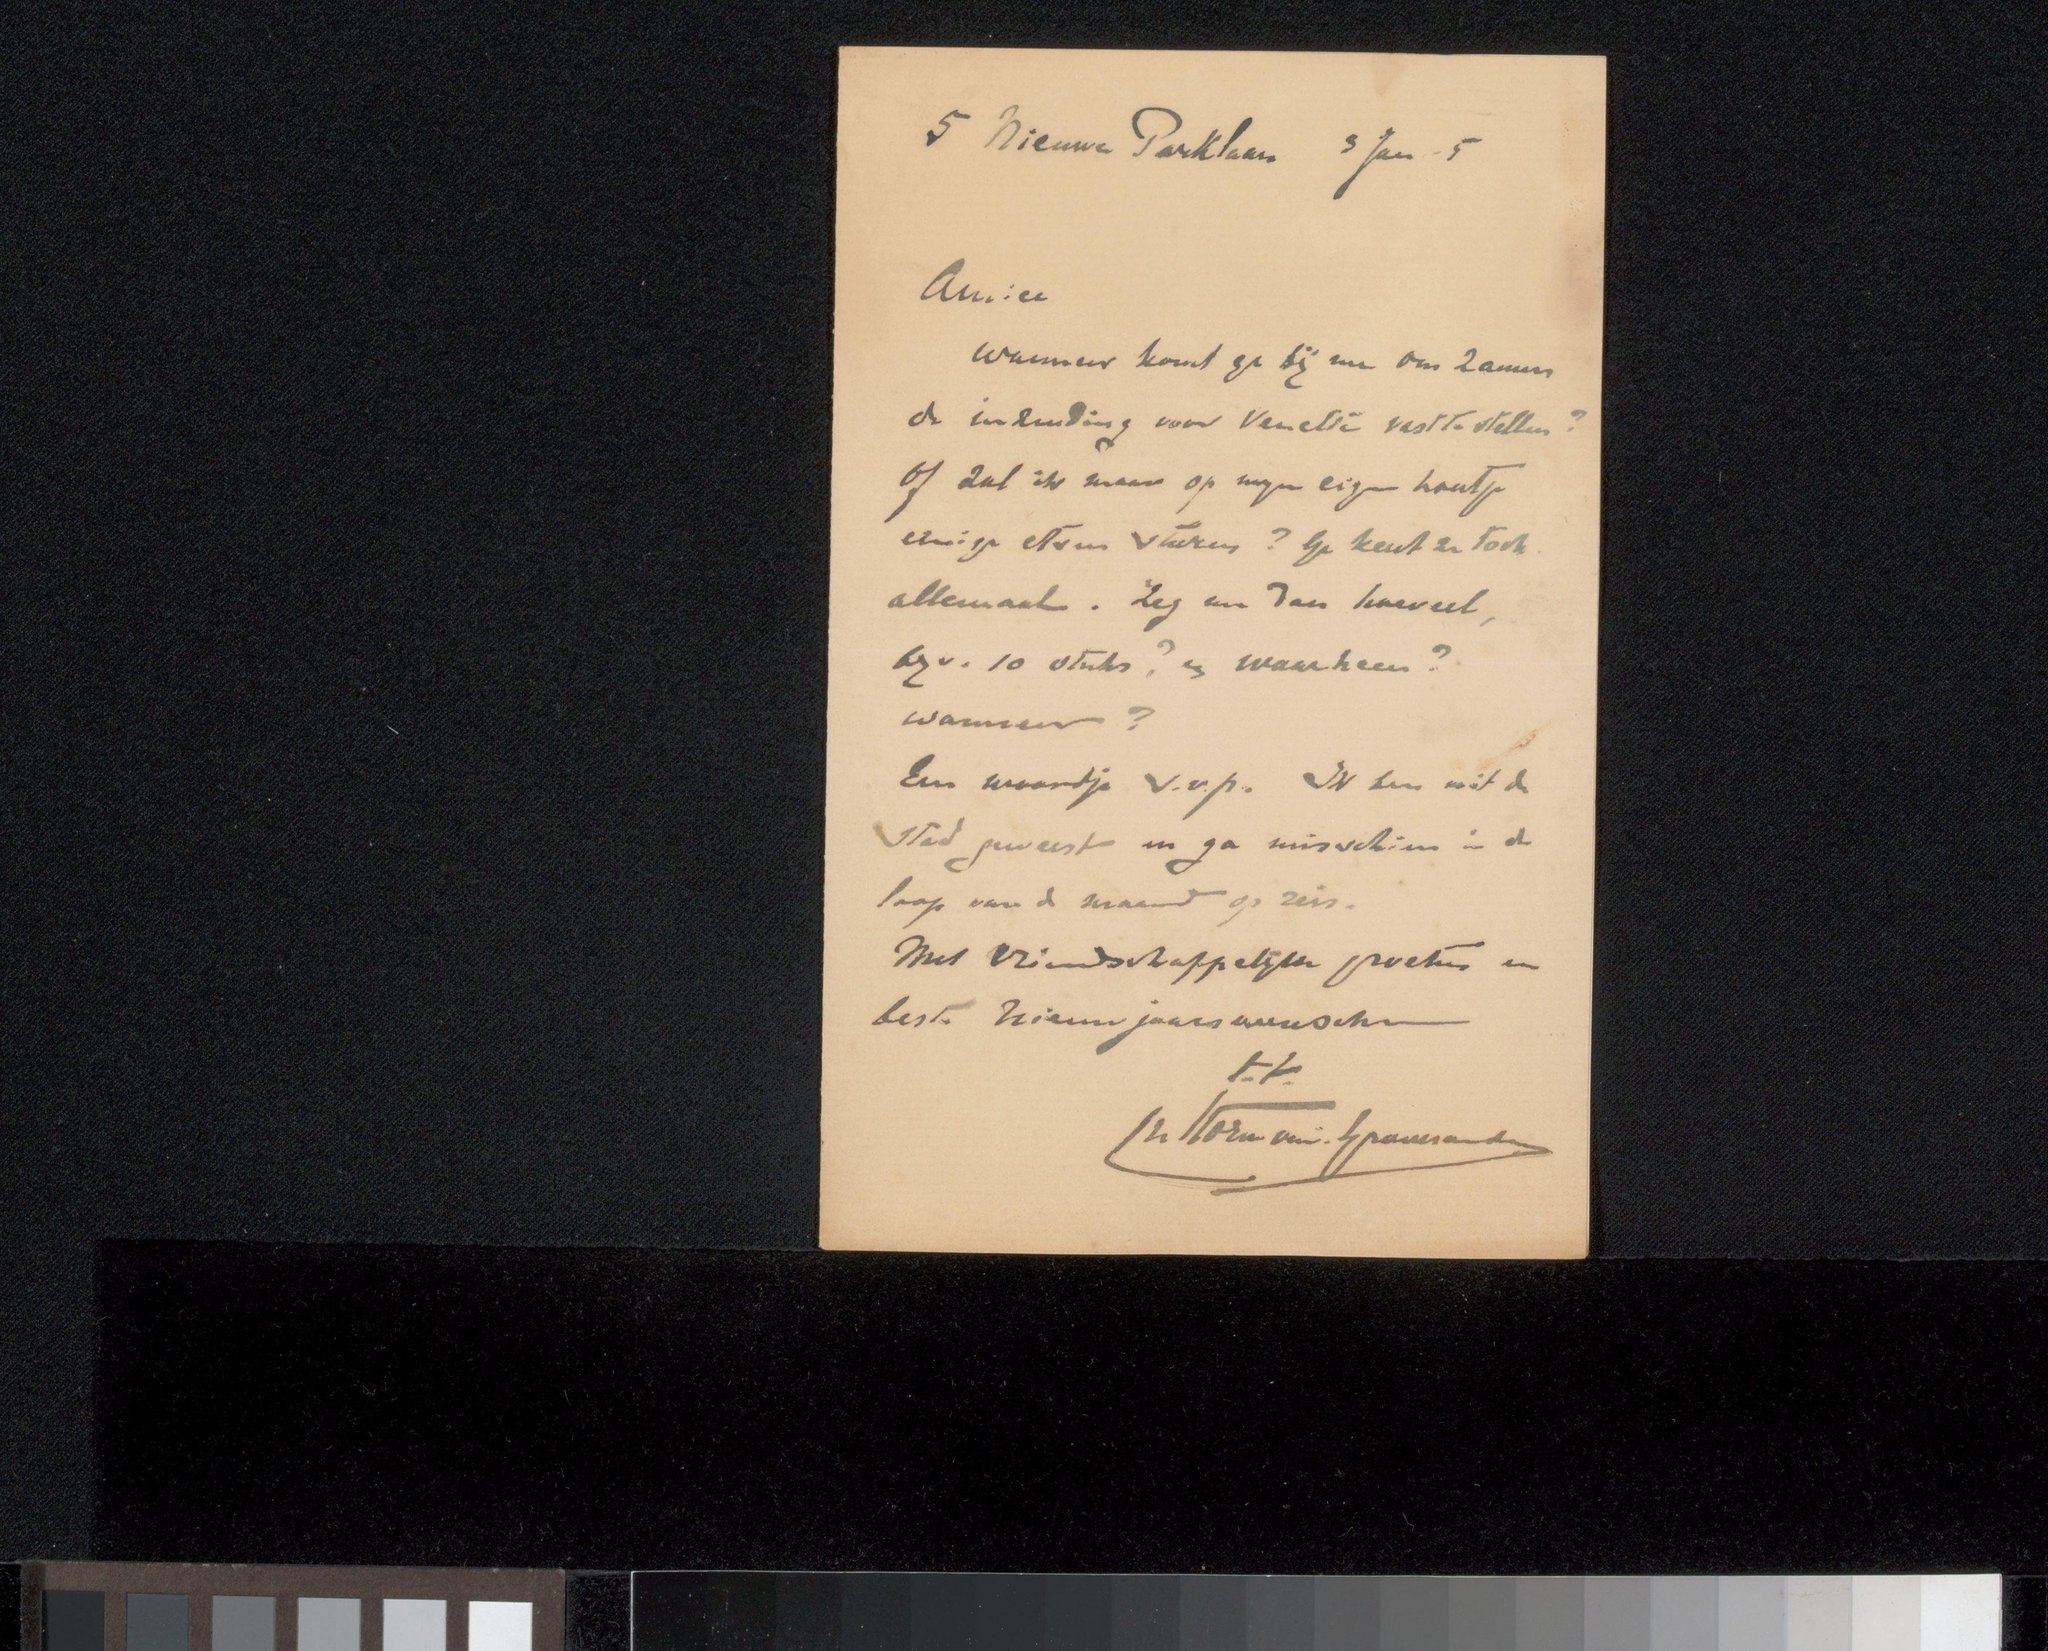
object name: letter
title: Brief aan Philip Zilcken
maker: carel nicolaas storm van s-gravesande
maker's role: draughtsman, print maker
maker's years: 1841-1924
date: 1905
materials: ink, paper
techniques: pen, writing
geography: the hague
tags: painter, philip zilcken, the graphic arts, exhibition ~ art, venice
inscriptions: collector's mark: ‘RPK’, watermark